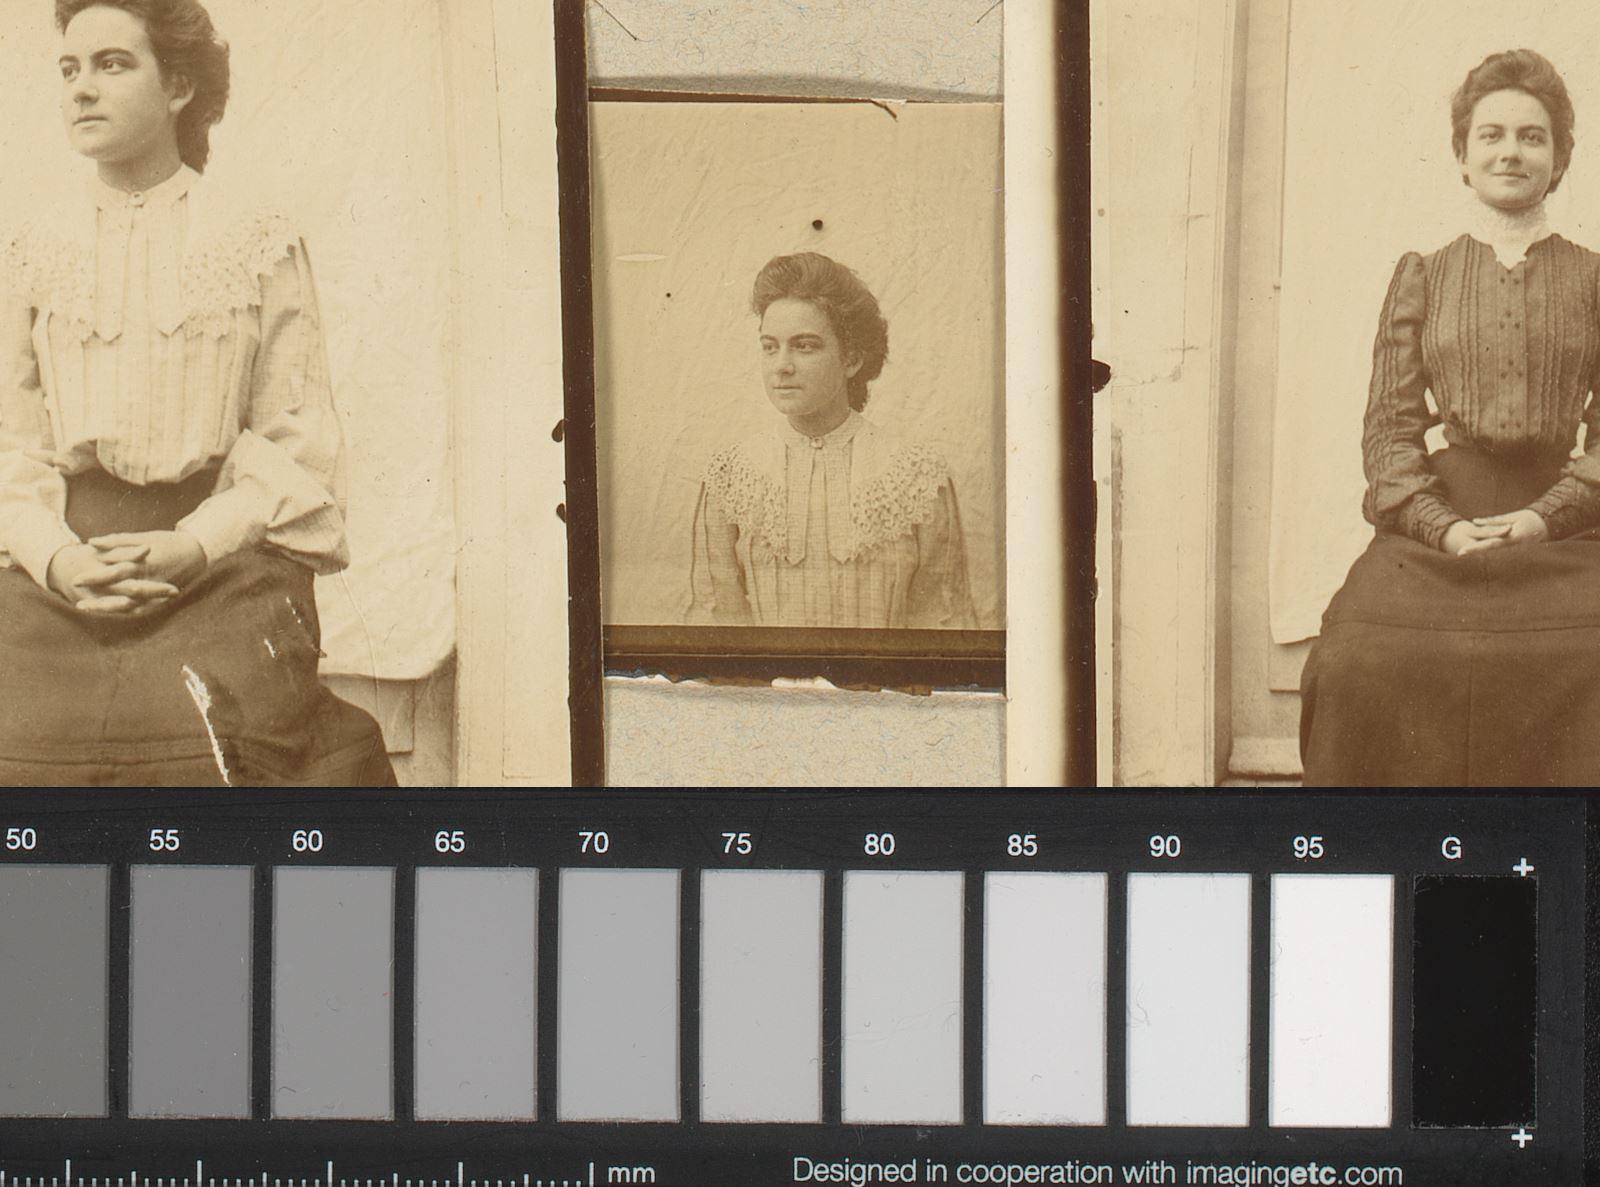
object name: photograph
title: Portret van een jonge vrouw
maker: Anonymous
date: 1897-1900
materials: paper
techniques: gelatin silver print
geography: france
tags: adolescent, young woman, maiden, historical persons, france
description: Over de foto is een ander negatief afgedrukt van een voorstelling van bomen.